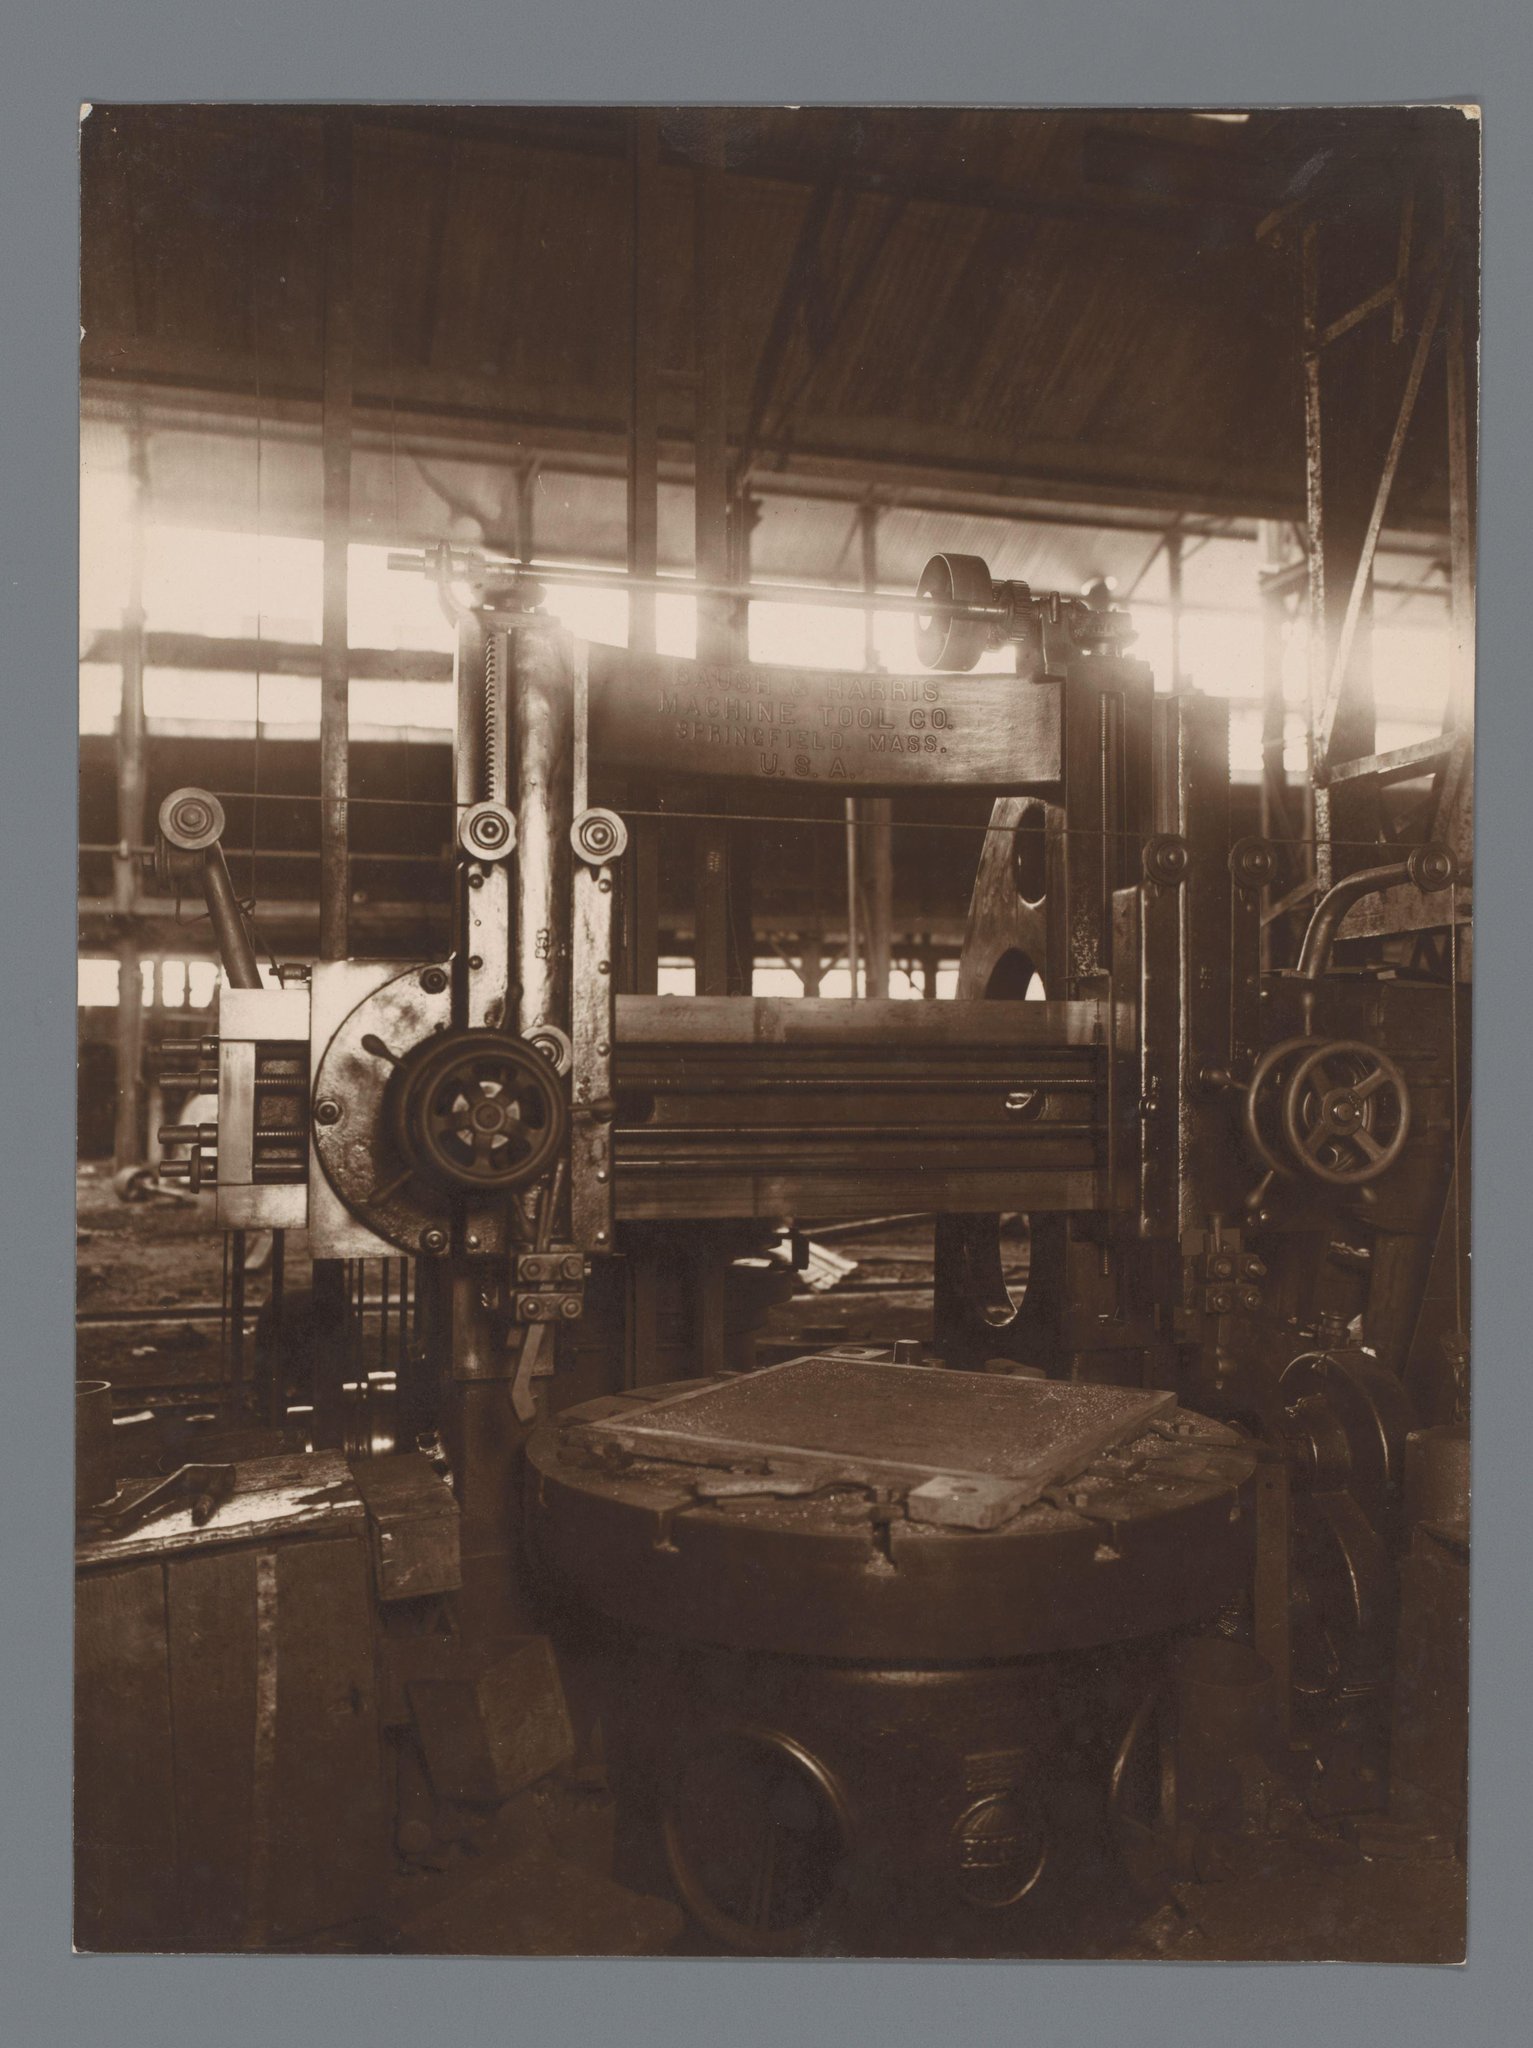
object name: photograph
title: Caroussel draaibank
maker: Anonymous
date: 1920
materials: photographic support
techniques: gelatin silver print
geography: surabaya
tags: colonial system, factory-interior, machine shop, machines; parts of machines; tools and appliances, java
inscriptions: date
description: Een caroussel draaibank van de Amerikaanse firma Bausch & Harris, gekocht in 1907. Onderdeel van de multomap met foto's van machines van de N.V. Machinefabriek Braat te Soerabaja, Soekaboemi en Jogyakarta, uit de periode 1908-1942.